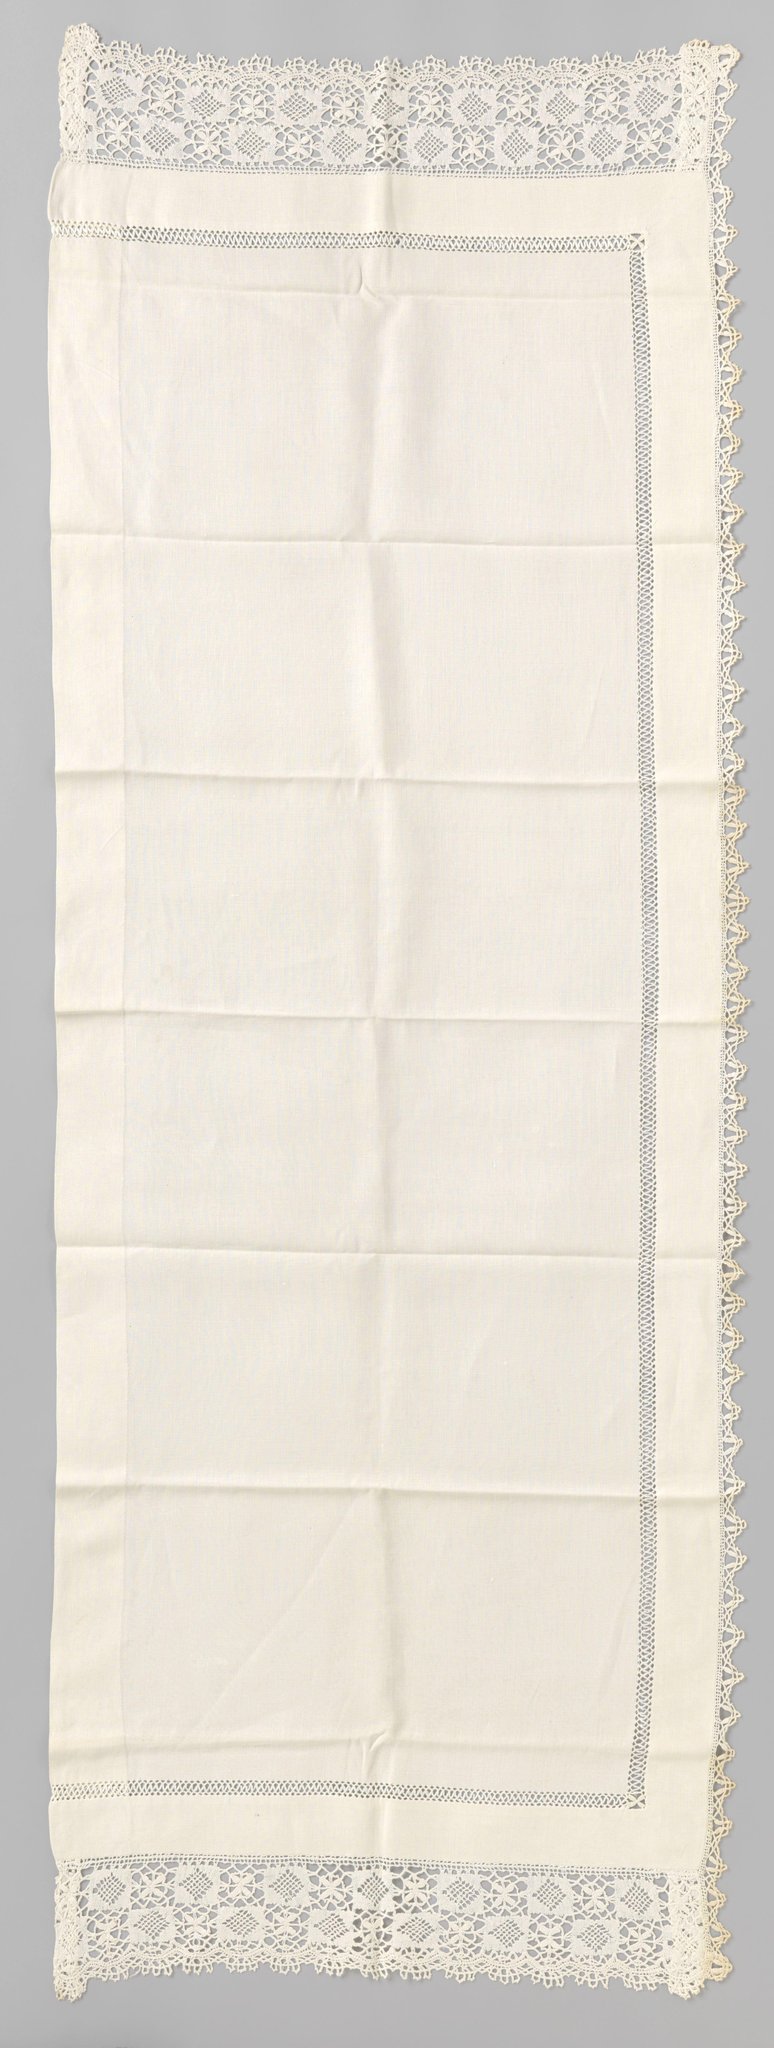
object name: kleed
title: Buffetloper van linnen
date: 1900-1925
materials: linen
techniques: lace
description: Buffetloper van linnen, afgezet met kant met een patroon van margrieten in spitsovalen. Zie tevens: BK-1972-159-b.